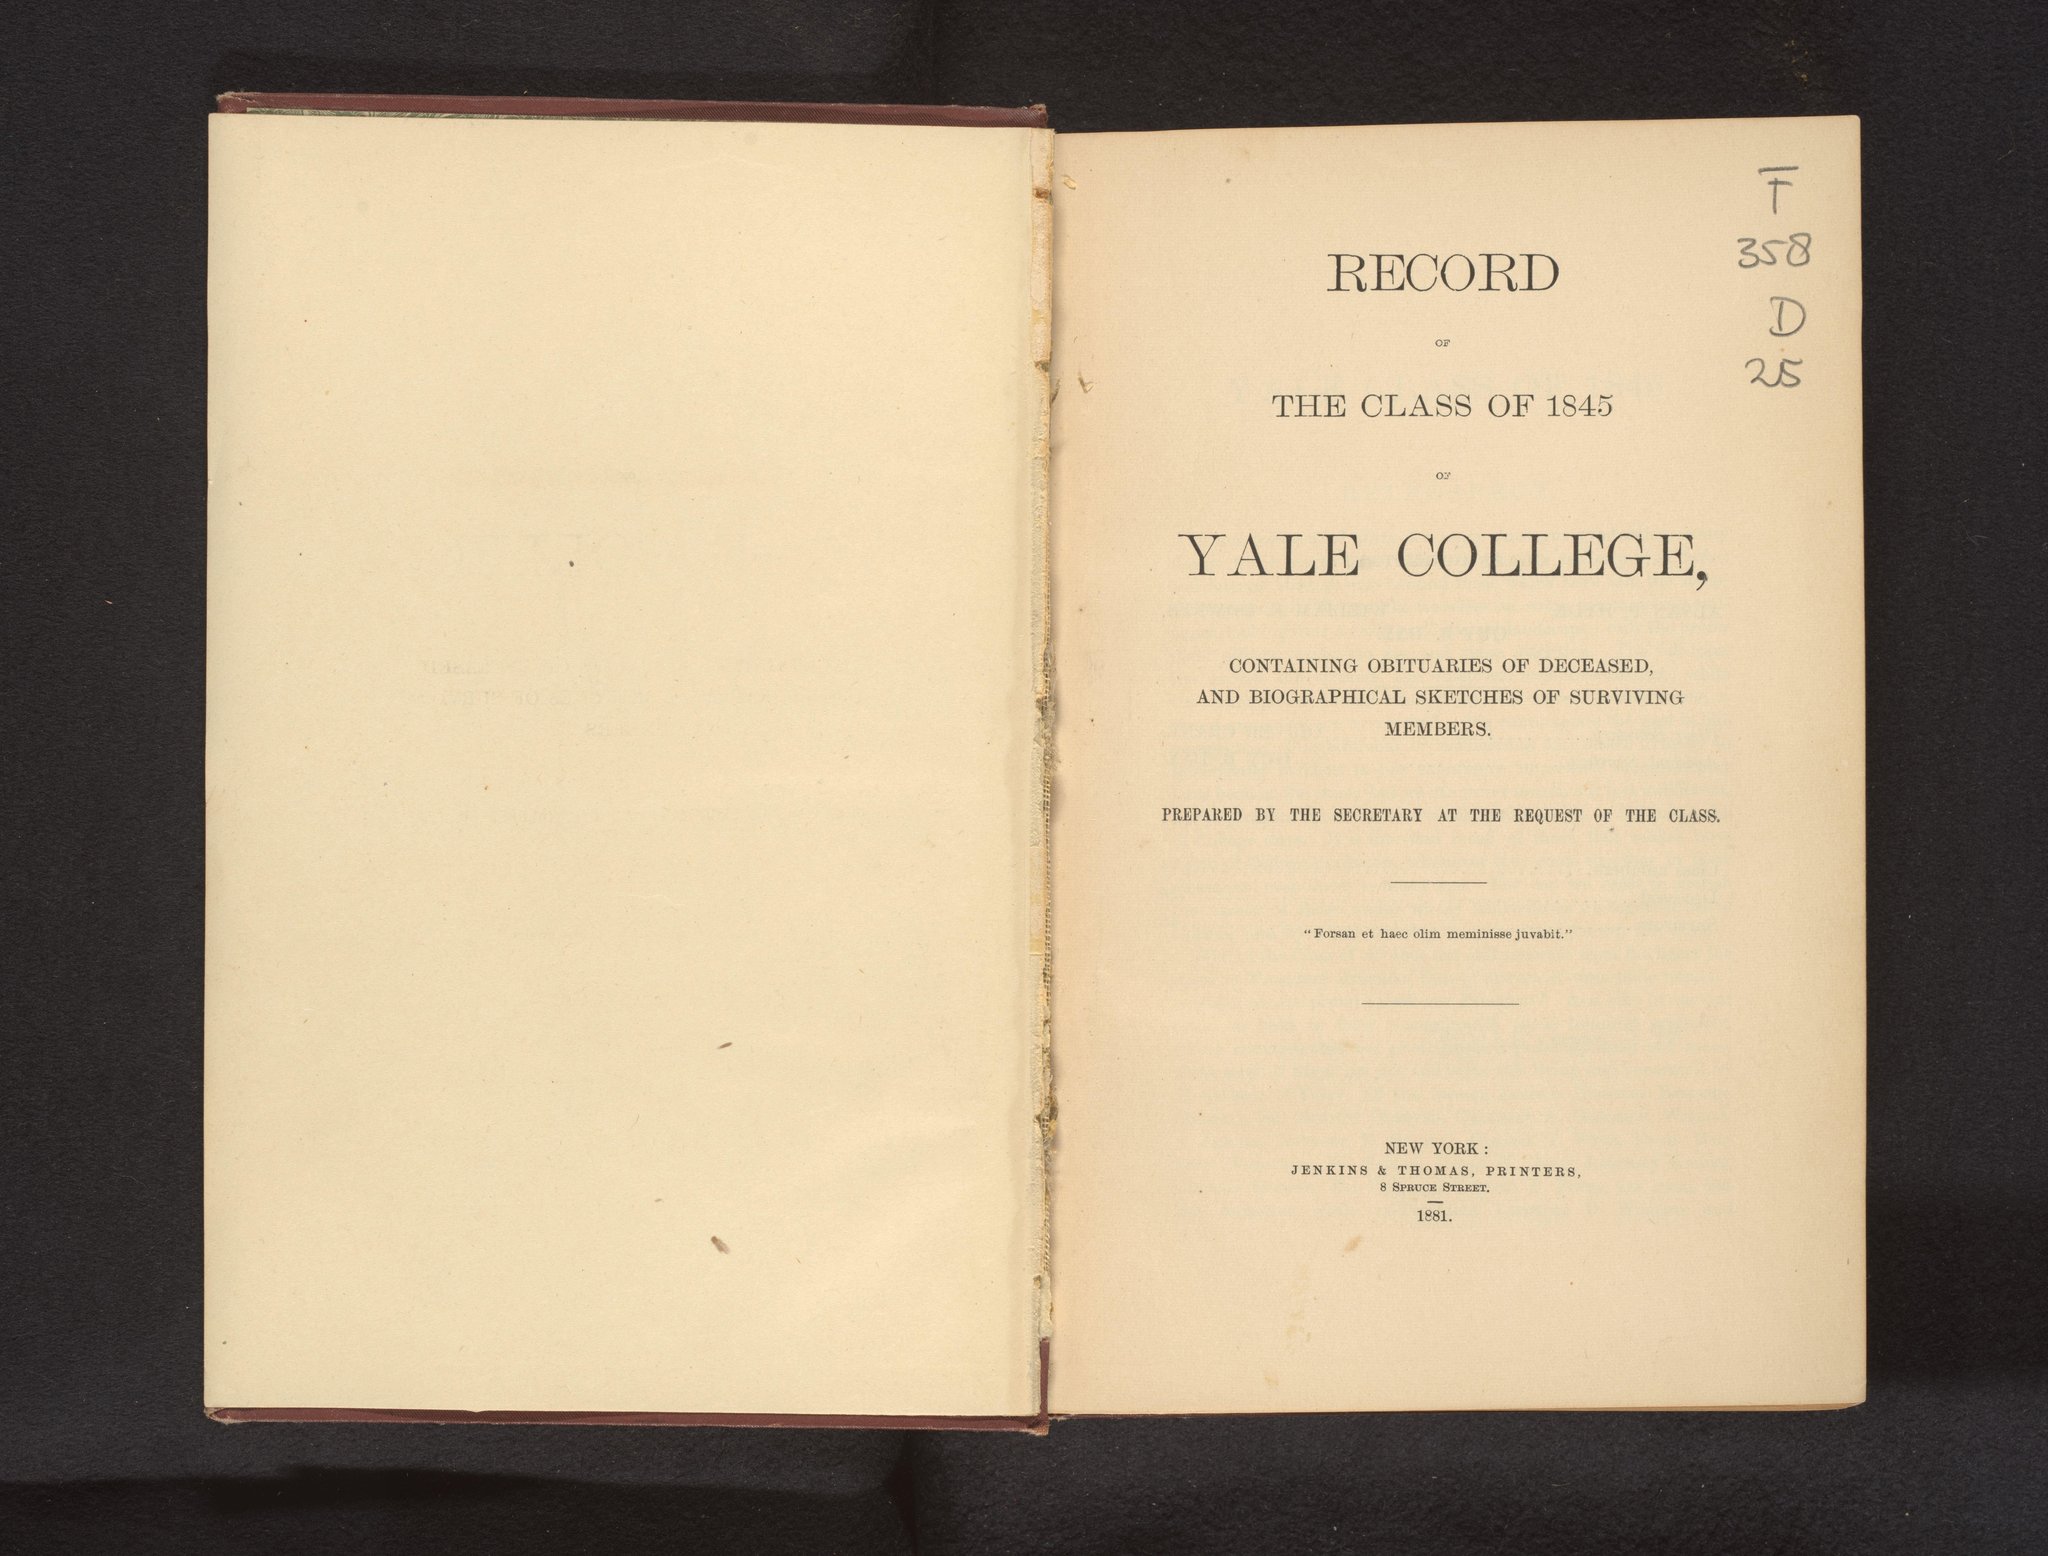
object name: book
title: Record of the class of 1845 of Yale College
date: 1881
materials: cardboard, linen, paper, photographic support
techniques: albumen print, printing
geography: new york city